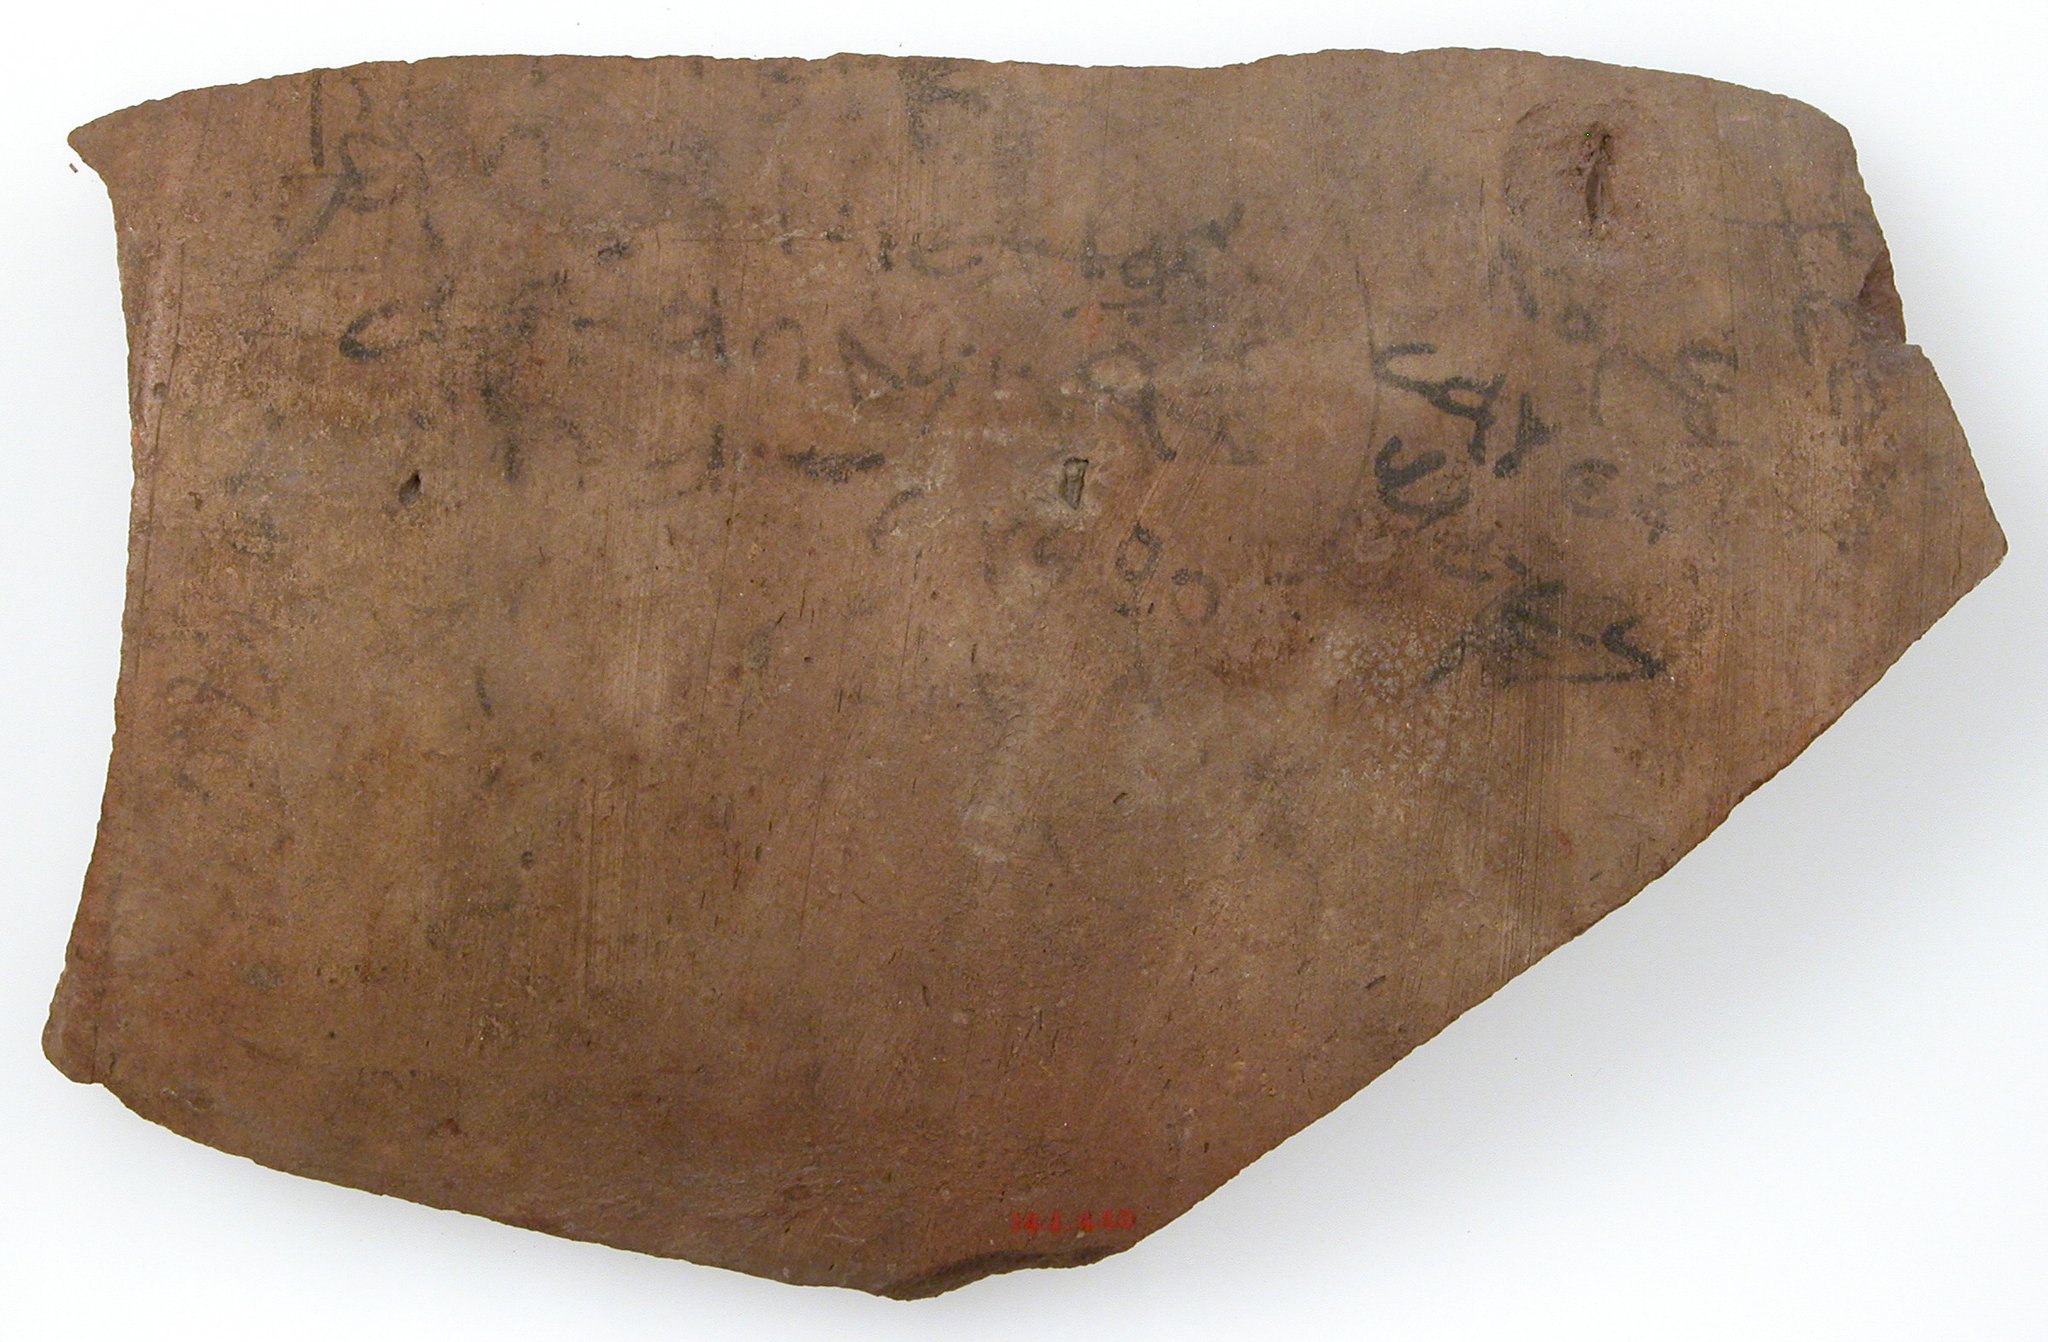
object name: ostrakon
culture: coptic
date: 580-640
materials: ink, pottery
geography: egypt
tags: coptic,documents